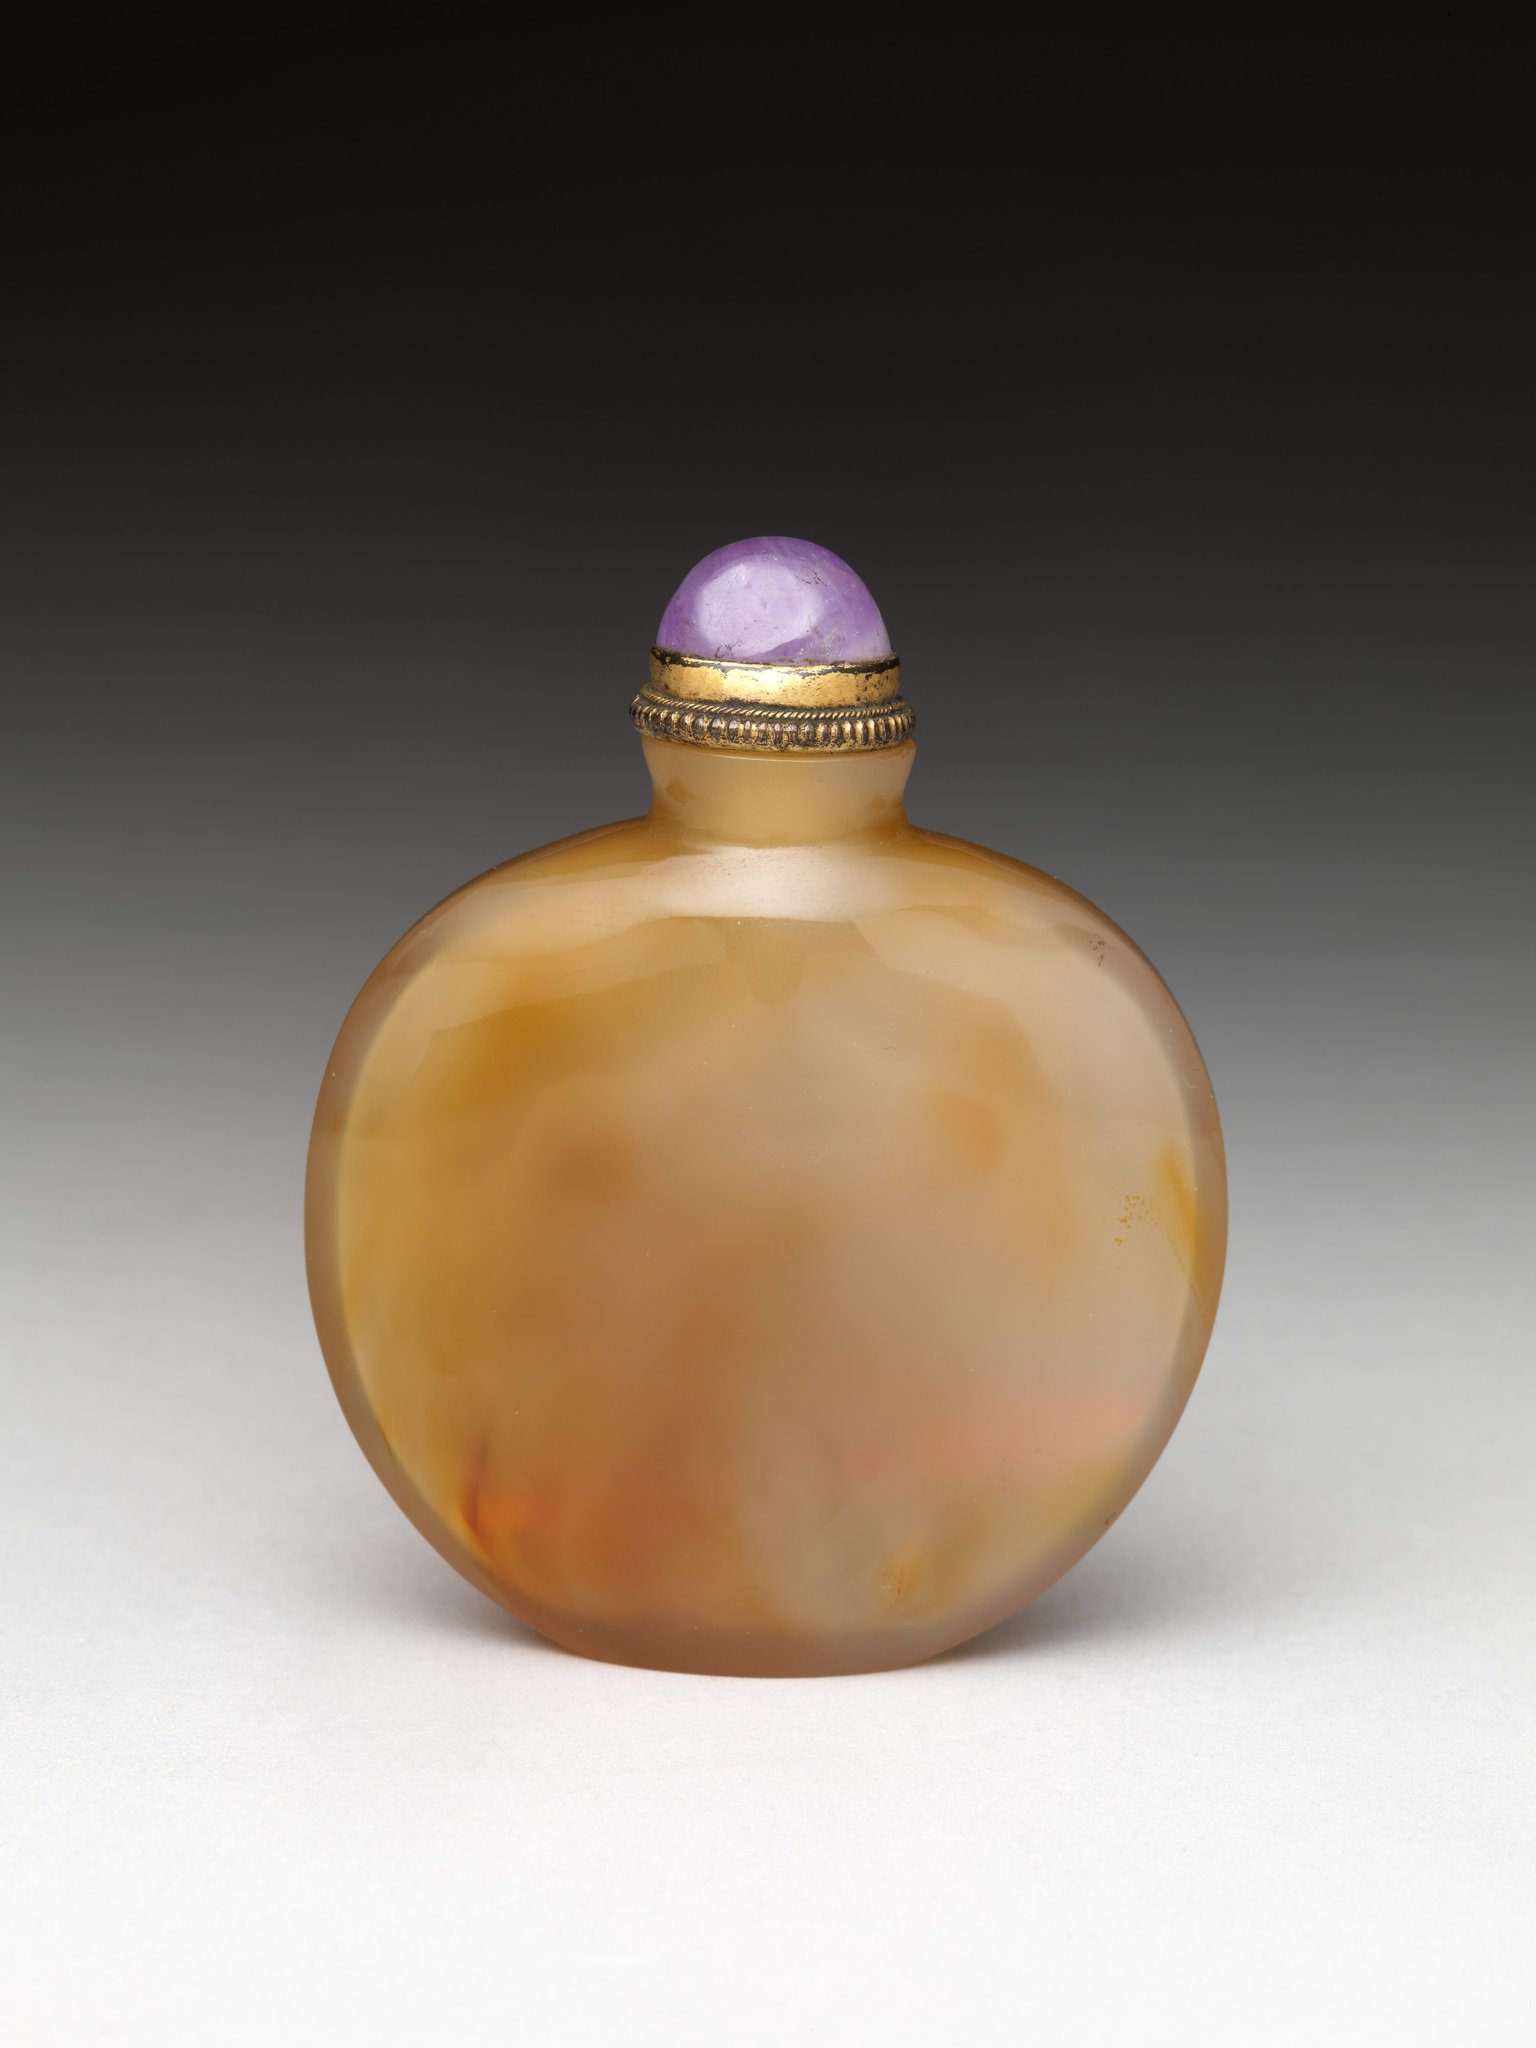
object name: snuff bottle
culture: chinese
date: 1767-1800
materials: stone, gemstone